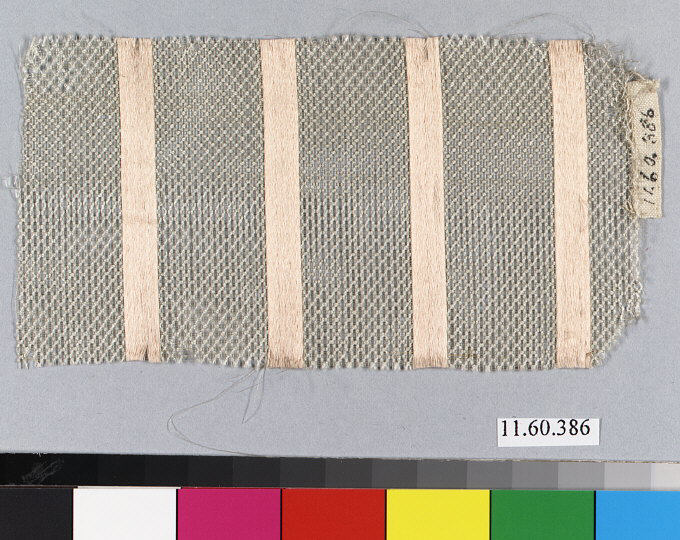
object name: fragment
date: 1801-1900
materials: silk